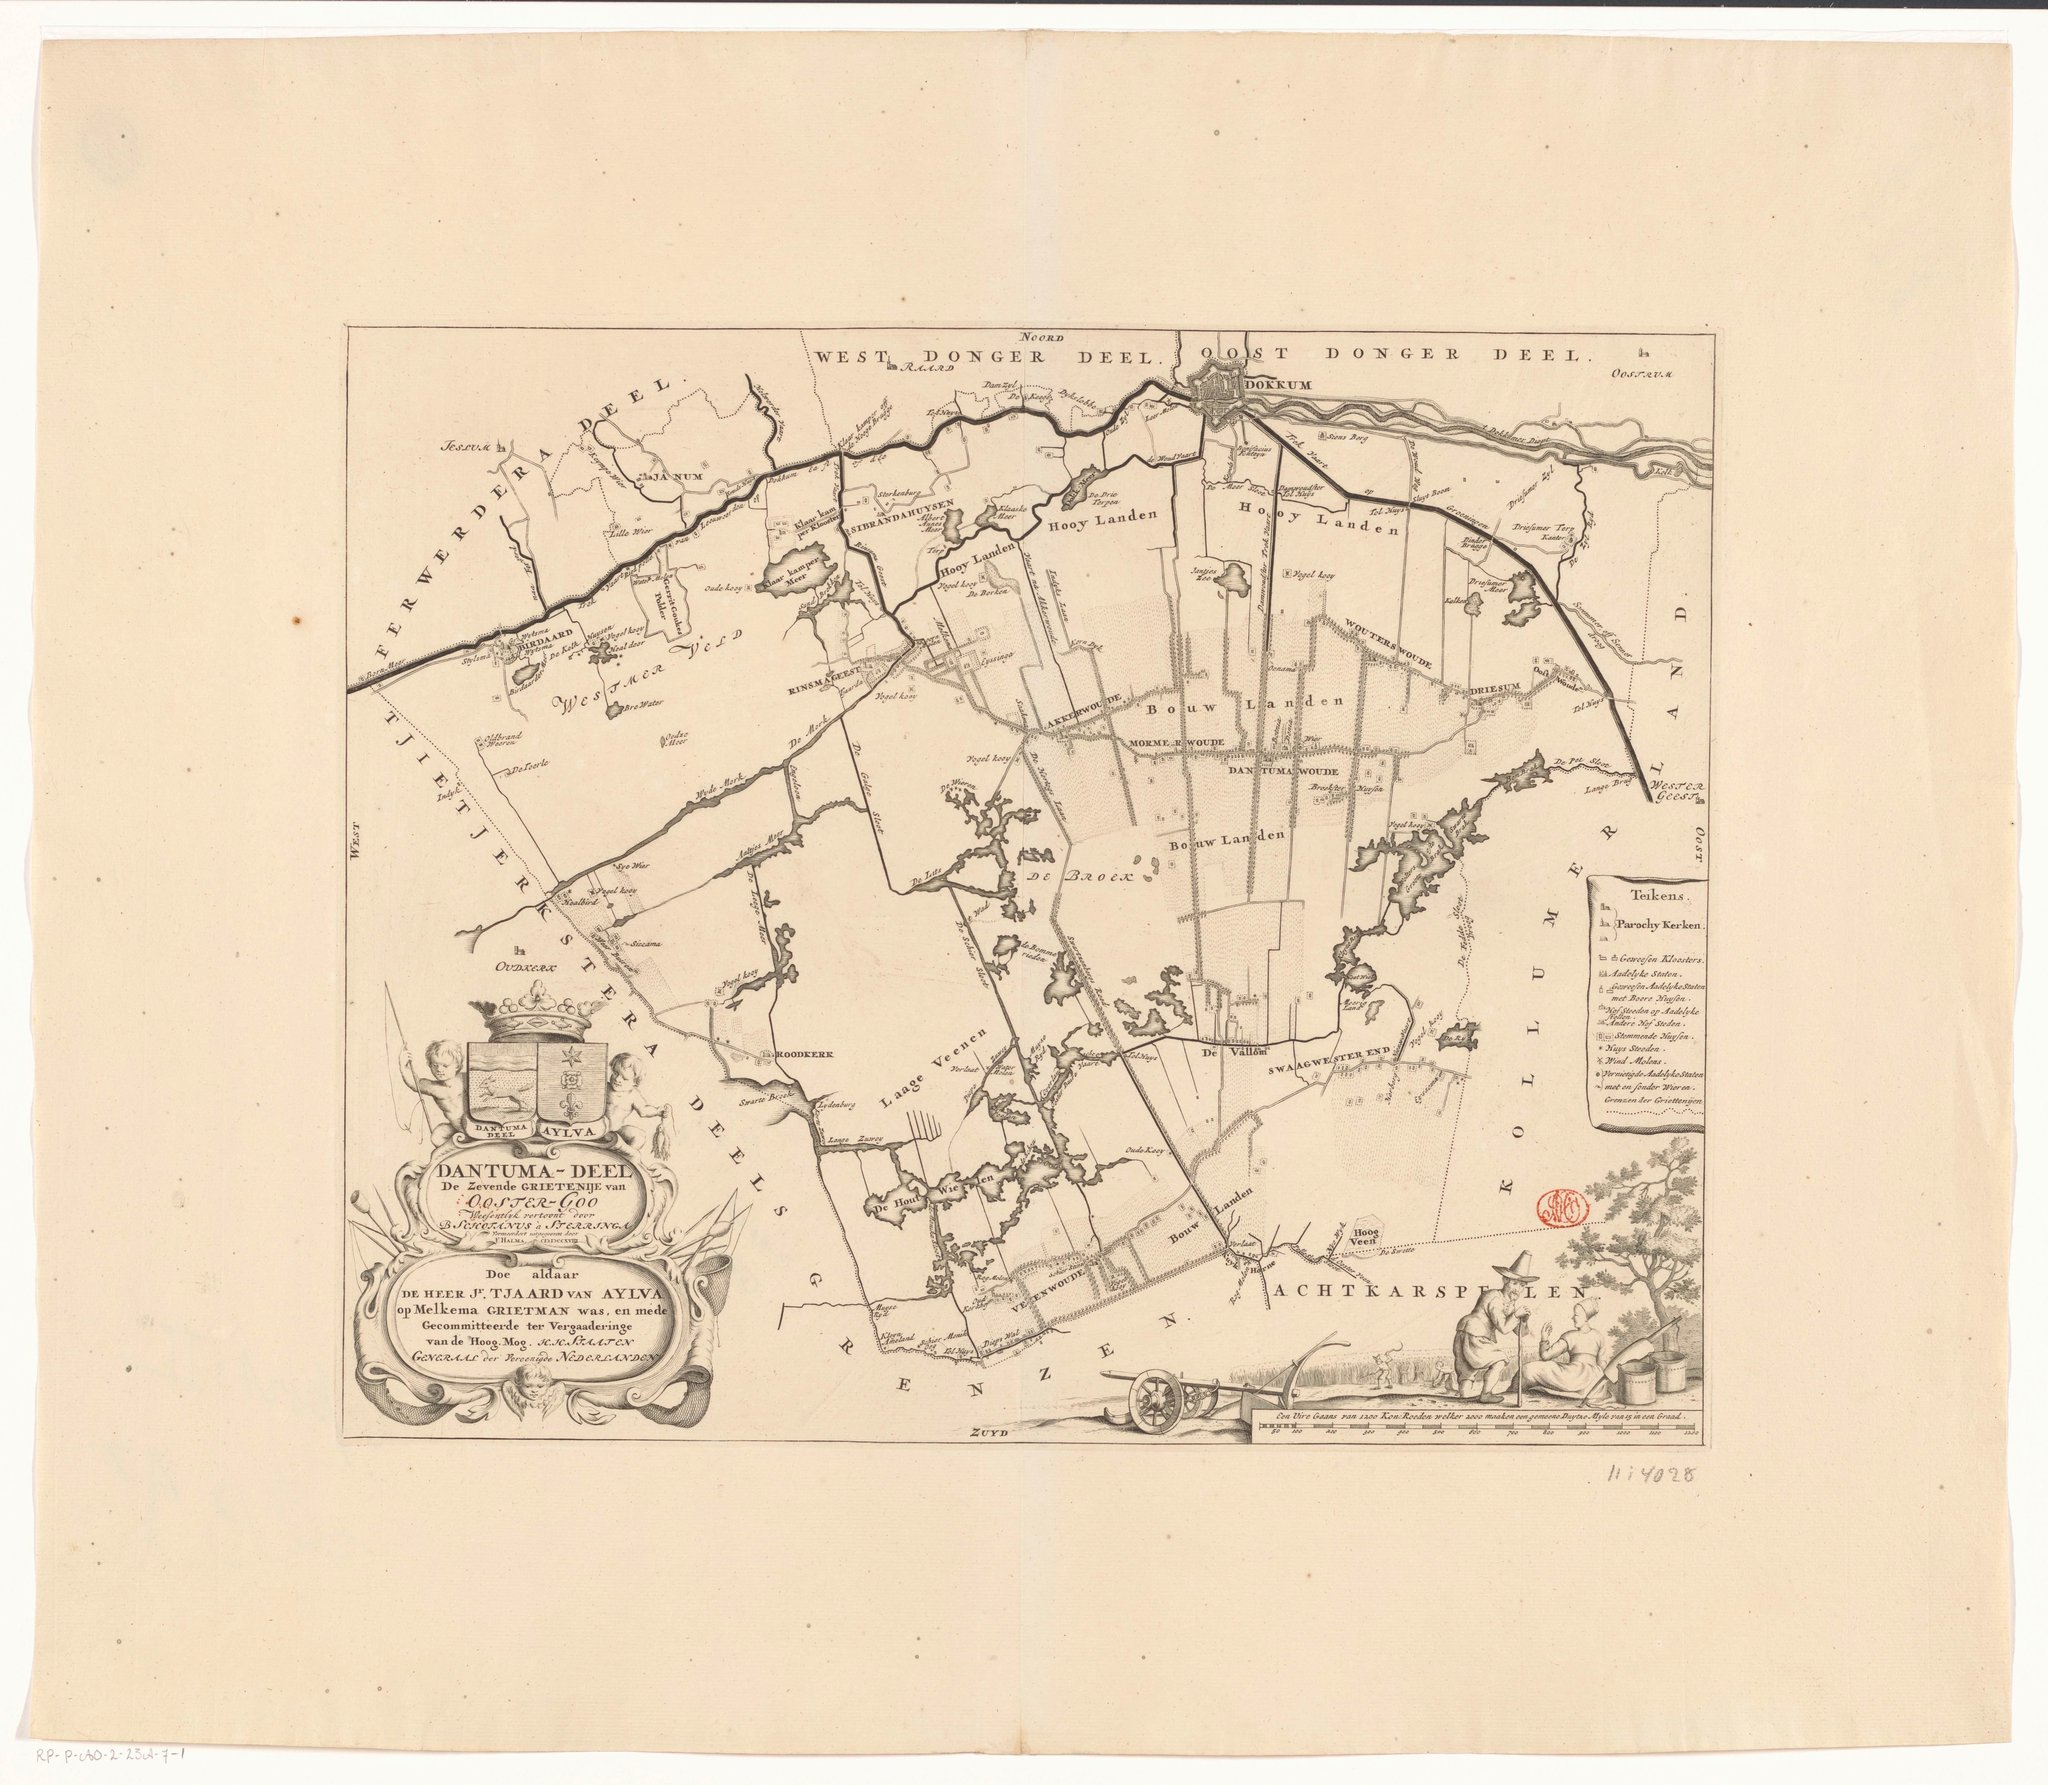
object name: print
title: Kaart van de grietenij Dantumadeel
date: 1698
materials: paper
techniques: engraving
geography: friesland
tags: coat of arms (as symbol of the state, etc.), maps of separate countries or regions, farmers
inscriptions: label: ‘264’, collector's mark: Lugt 2228, collector's mark: 195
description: Linksonder cartouche met titel, bestuurlijke informatie over de grietenij en de wapens van Dantumadeel en van grietman jonker Tjaard van Aylva. Rechts legenda, rechtsonder een schaalstok: Een uire van 1200 kon: roeden welker 2000 maaken een gemeene Duytze myle van 15 in een graad. Daaromheen een aantal landbouwers.